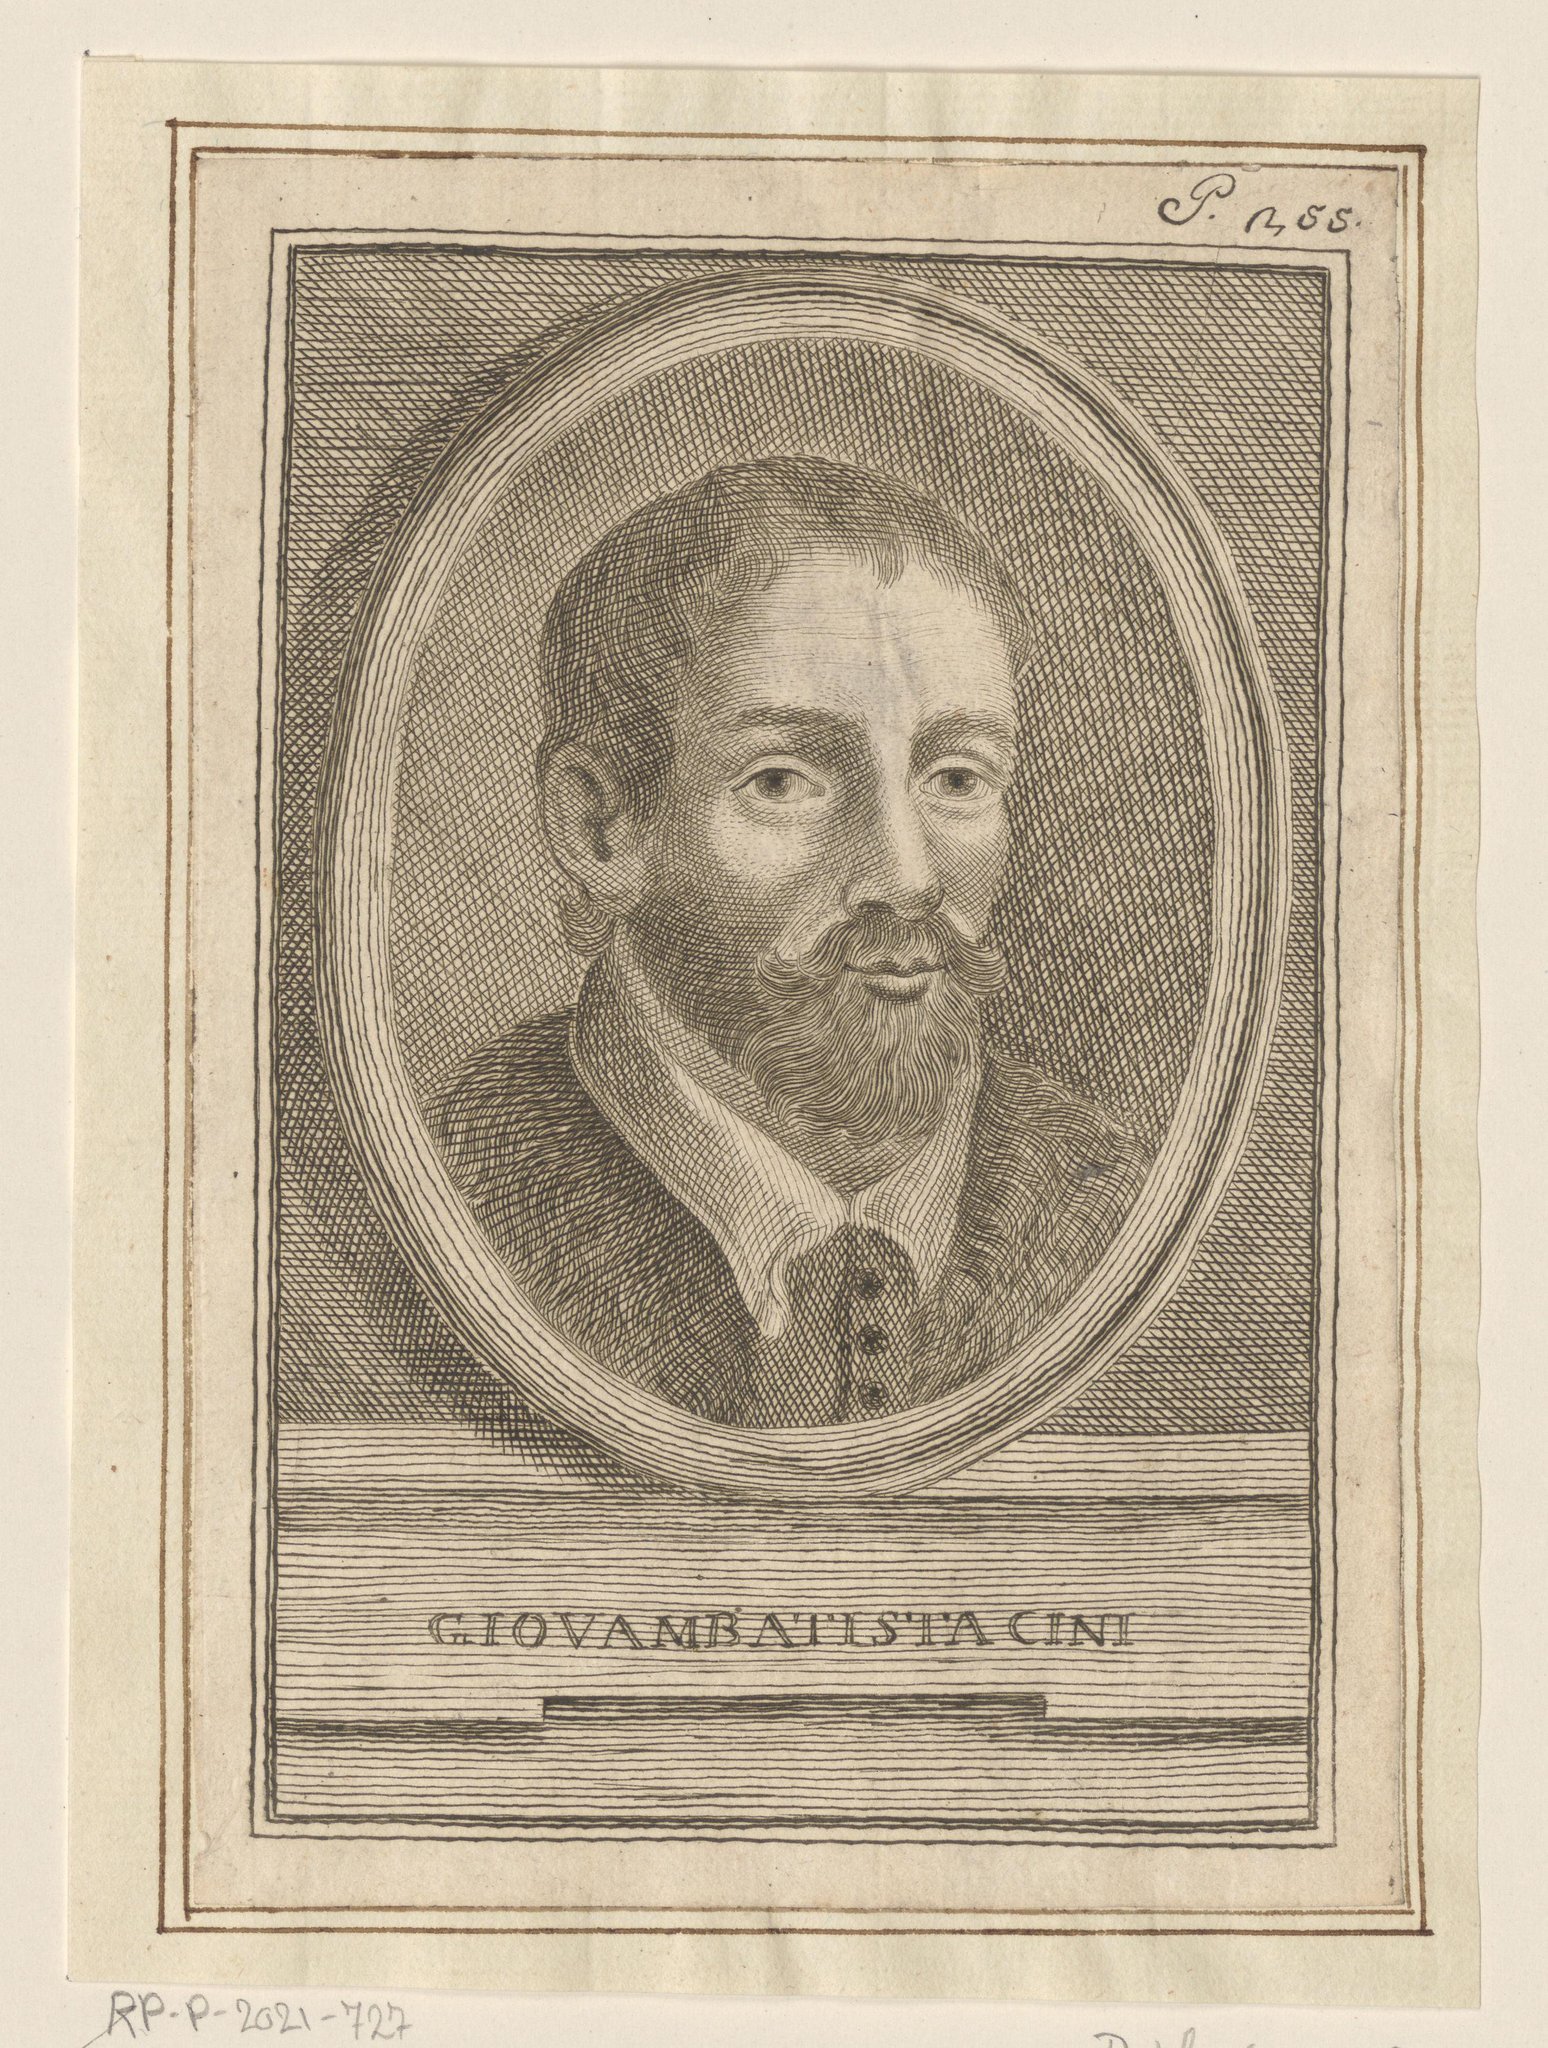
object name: print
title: Portret van Giovan Battista Cini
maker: Anonymous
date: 1580-1699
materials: paper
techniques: engraving, etching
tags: historical persons